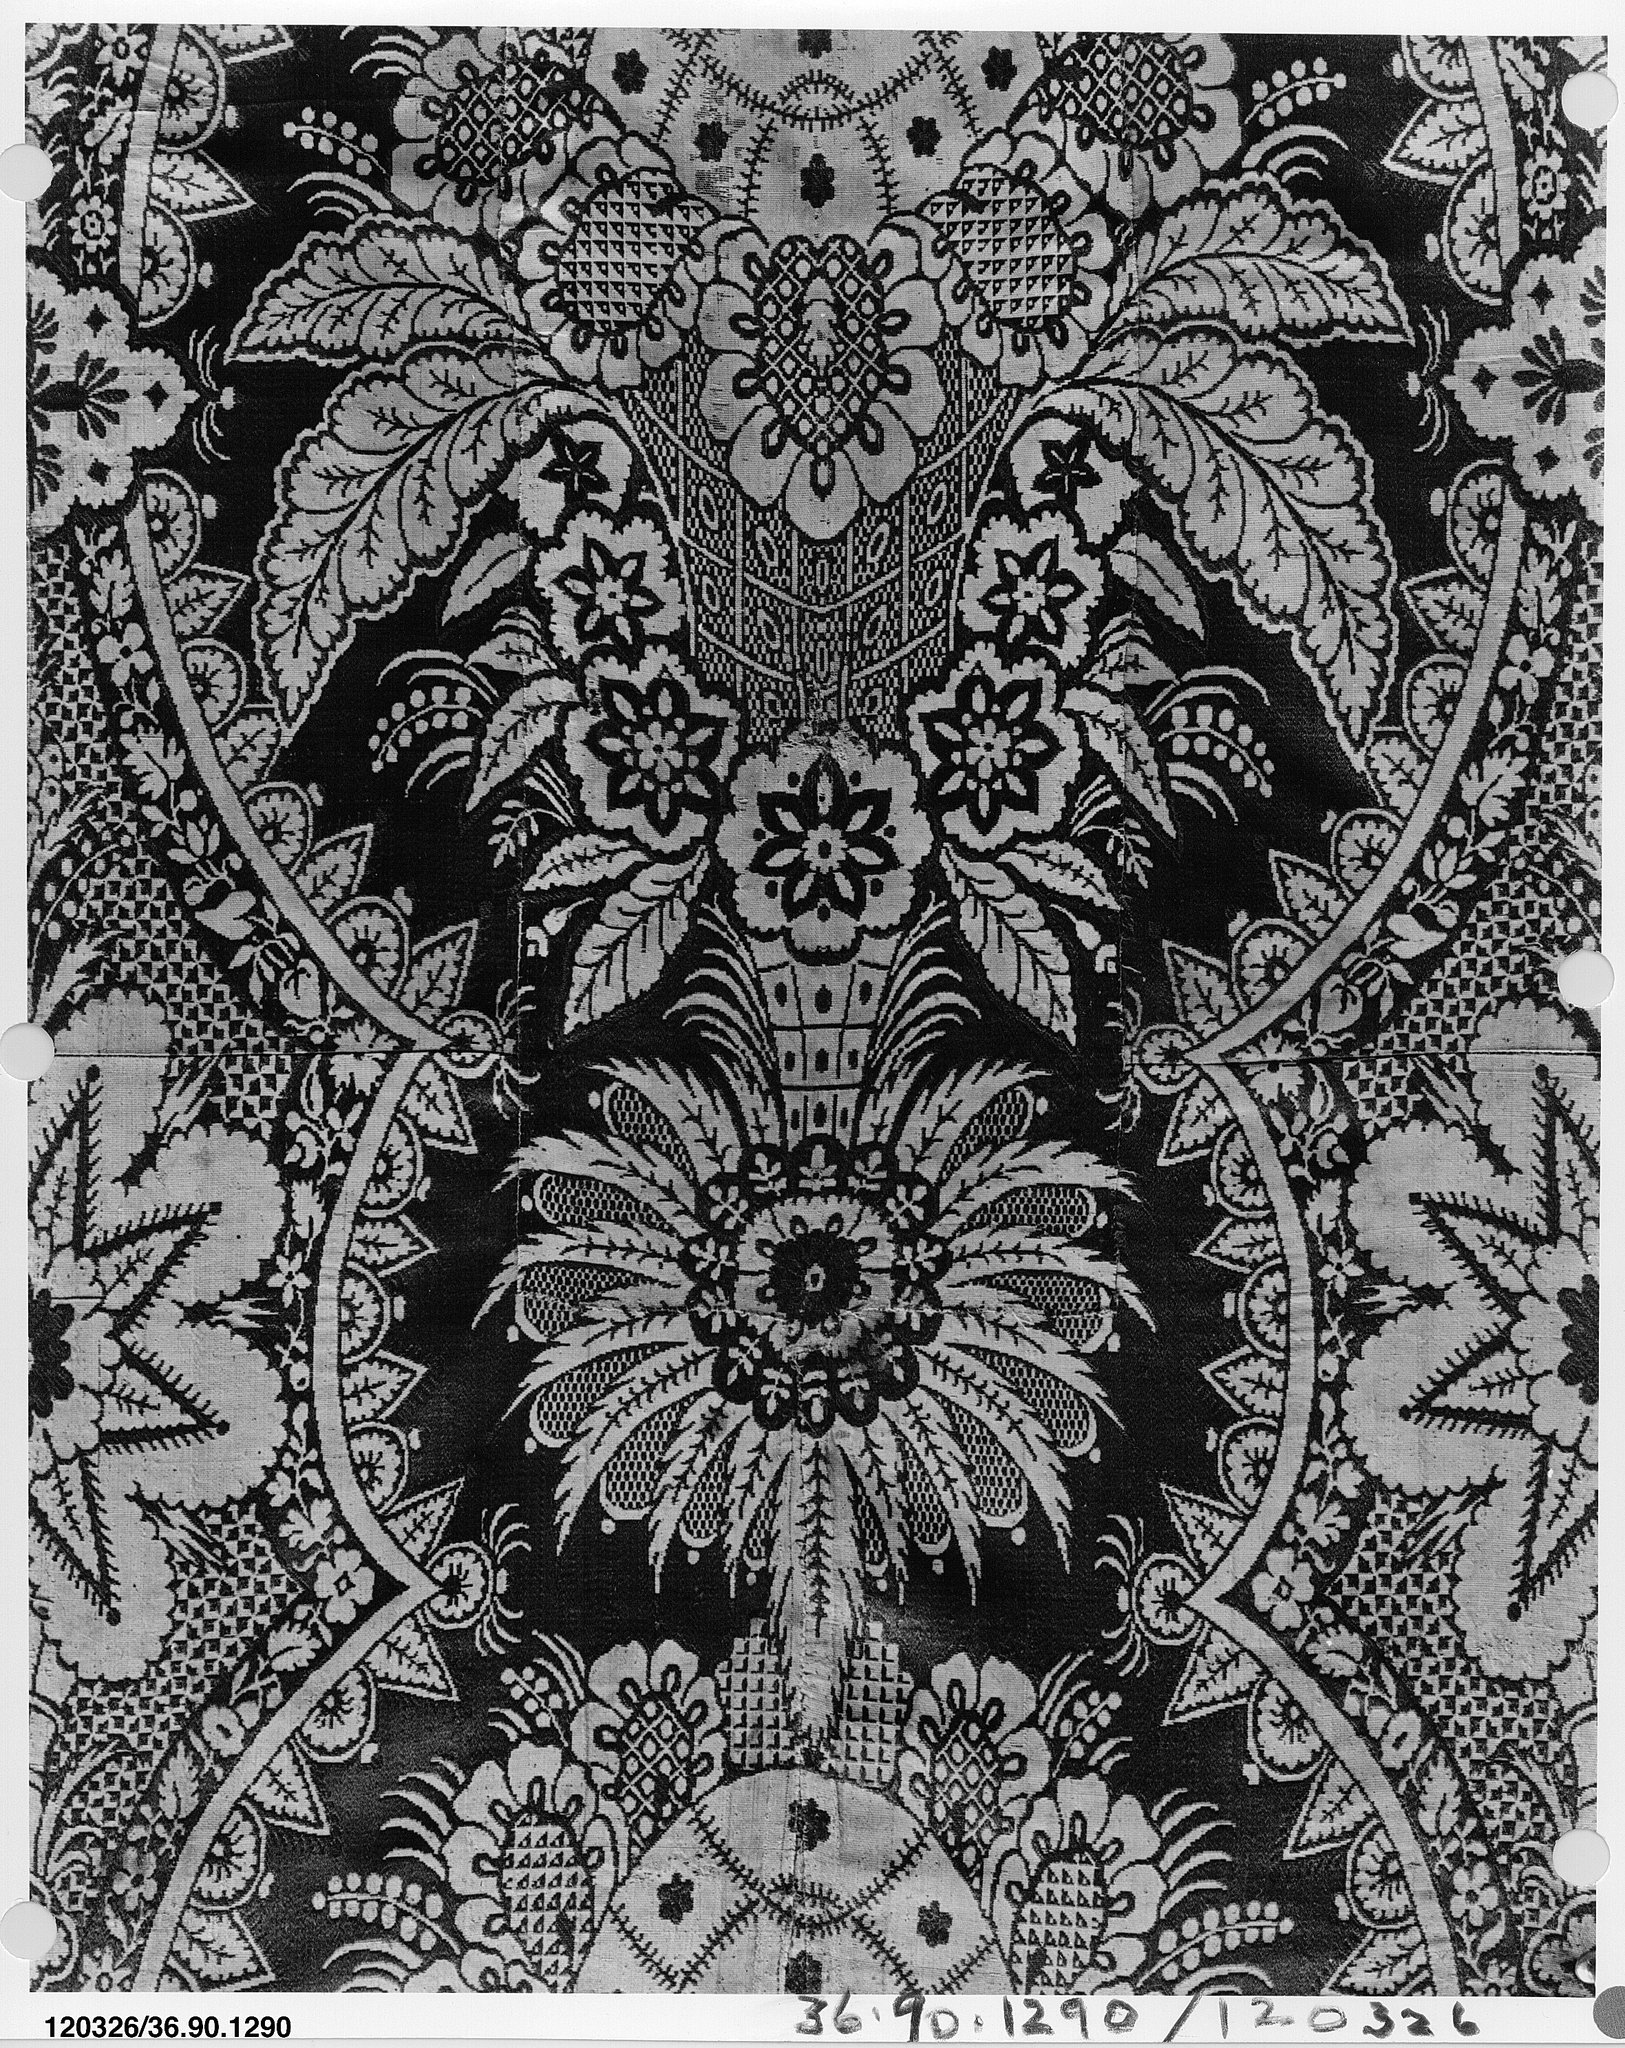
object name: piece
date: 1720-1725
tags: flowers,leaves